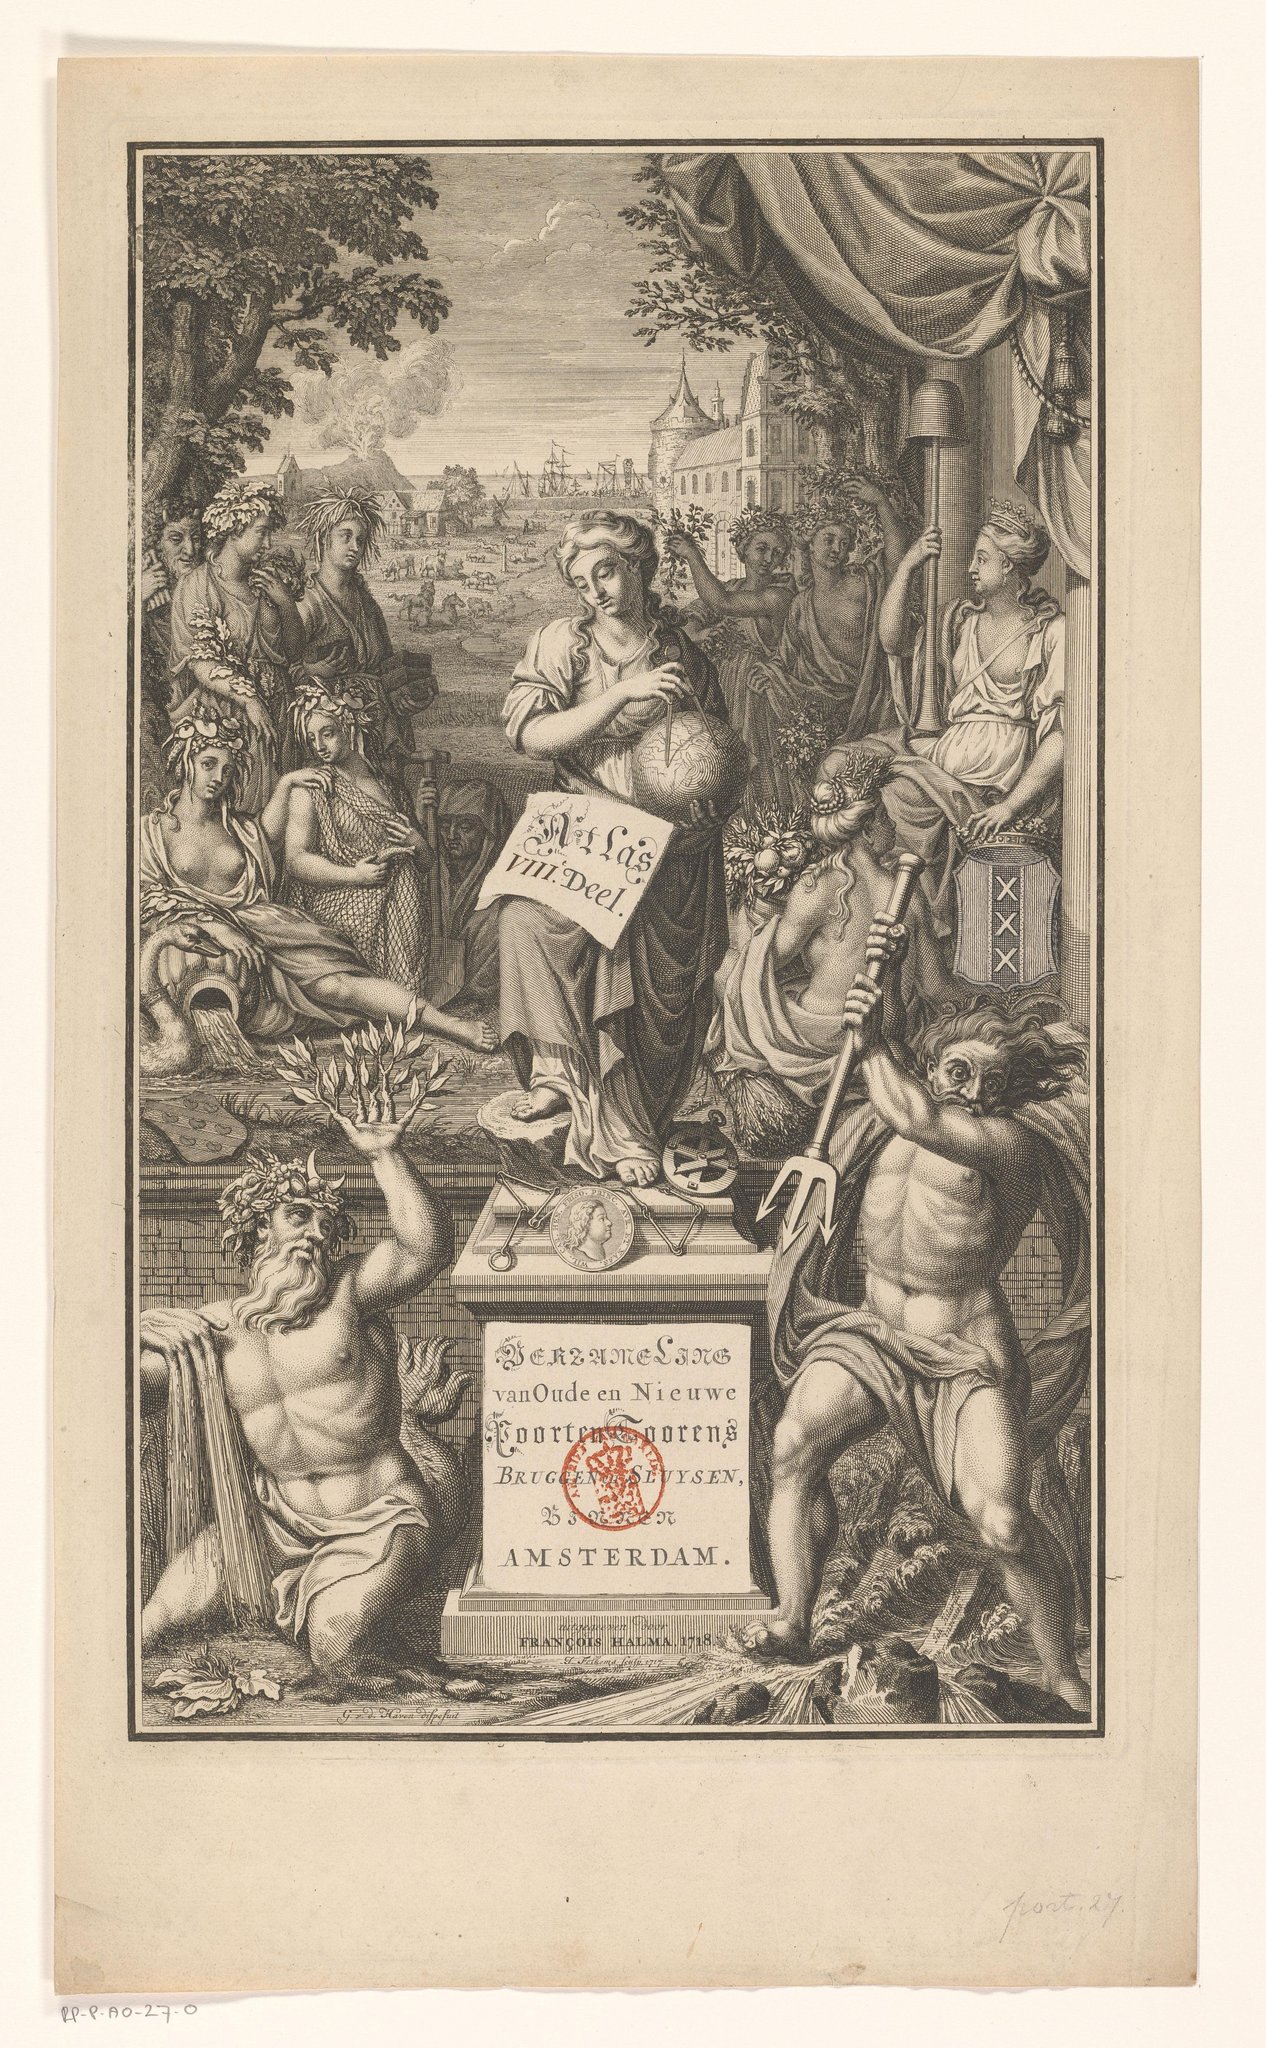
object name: print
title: Atlas VIIIe. Deel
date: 1717-1718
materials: ink, paper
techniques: engraving, etching, pen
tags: commercial fishery, (story of) ceres (demeter), coat of arms (as symbol of the state, etc.) (+ city; municipal), peat-cutting, 'astronomia', 'cosmografia'; 'cosmografia' (ripa), personifications of countries, nations, states, districts, etc., river-gods, 'corografia', 'geografia', 'hidrografia' (ripa), agriculture, fruitfulness, productiveness, fertility, fecundity; 'fecondità' (ripa), (story of) flora, neptune as lord of the sea, amsterdam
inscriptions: collector's mark: Lugt 19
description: Deze prent is hier gebruikt als titelprent van een deel van een ongebonden atlas; een verzameling cartografische en topografische prenten en tekeningen. Oorspronkelijk was de prent echter bedoeld als titelpagina voor een gebonden atlas met kaarten van Friesland, waardoor een deel van de hier volgende beschrijving betrekking heeft op die context. Op het voetstuk in het midden staat de personificatie van de cartografie, met in haar hand een aardbol die ze met een passer meet. Op haar bovenbeen rust een blad met het handgeschreven deel van de atlas (oorspronkelijk een kaart van Friesland). Aan haar voeten een meetketting, een rond (land)meetkundig instrument en een portret van Willem IV van Oranje-Nassau. Daaronder de handgeschreven titel van dit deel van de atlas. Ze houdt een wakend oog op Wispelturigheid (Wispeltuer), linksonder. Oorspronkelijk staat hij voor de wispelturigheid waar het Friese land zich naar moest schikken: een bos kon opeens onder water staan, want zijn lichaam smelt door het zoute water van de zee. Linksboven zijn hoofd een wapenschild met het wapen van Friesland (met schuinbalken en pompeblêden). De dreiging van de zee is rechtsonder verbeeld door een onstuimige Neptunus (Zeevoogd). Links en rechts van Cartografie nog meer figuren die oorspronkelijk betrekking hadden op Friesland en haar vruchtbare natuur, visserij en landbouw. Links, met haar arm leunend op een kruik waar water uitstroomt, een stroomgodin (Stroomvoogdess) met rechts van haar de personificatie van de visserij (Visschevang). Boven hen van links naar rechts: een sater met fluit als personificatie van de natuur (Natuer), de personificatie van de bossen met eikenloven (Woudman) en personificatie van de turfwinning (vrouw Veenbrand). Rechtsonder haar vrouw Onland, die rouwt om de schade die de turfwinning aan het land veroorzaakt. Rechts van Cartografie zit Flora en/of Ceres (vrouw Veldgewas) met korenaren en cornucopia, ze staat voor de overvloed die voortvloeit uit het land. Boven haar, op de achtergrond, twee vrouwelijke personificaties die in verband staan met groene weides en/of grasvelden: Beemdeheil en Graazevol. Rechts, met in haar ene hand een bazuin met daarop een vrijheidshoed en in de andere hand een schild met het wapen van Amsterdam, de personificatie van het gebied van dit deel van de atlas (oorspronkelijk de Friese Maagd met het provinciewapen met twee leeuwen). Op de achtergrond een landschap met kenmerkende Friese elementen, zoals het Sjaerdemaslot te Franeker en de vuurspuwende Rode Klif te Gaasterland (zou in de oudheid een vulkaan zijn geweest).